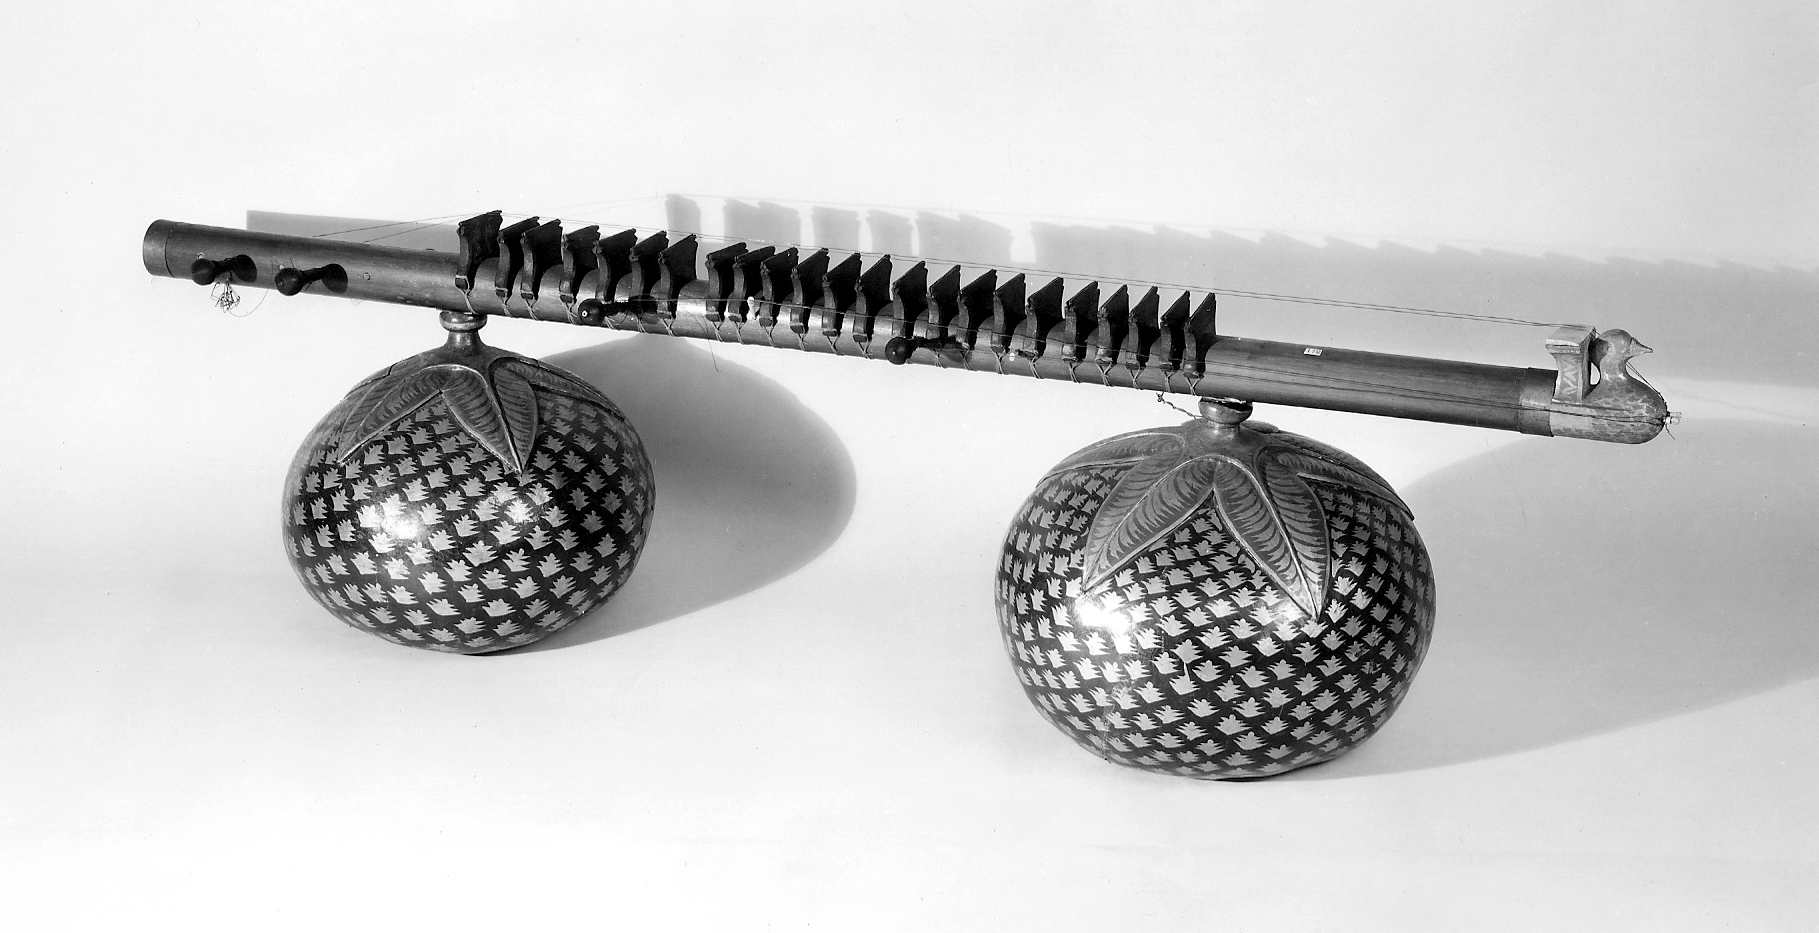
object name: māhatī vīṇa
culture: indian, north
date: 1885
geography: india